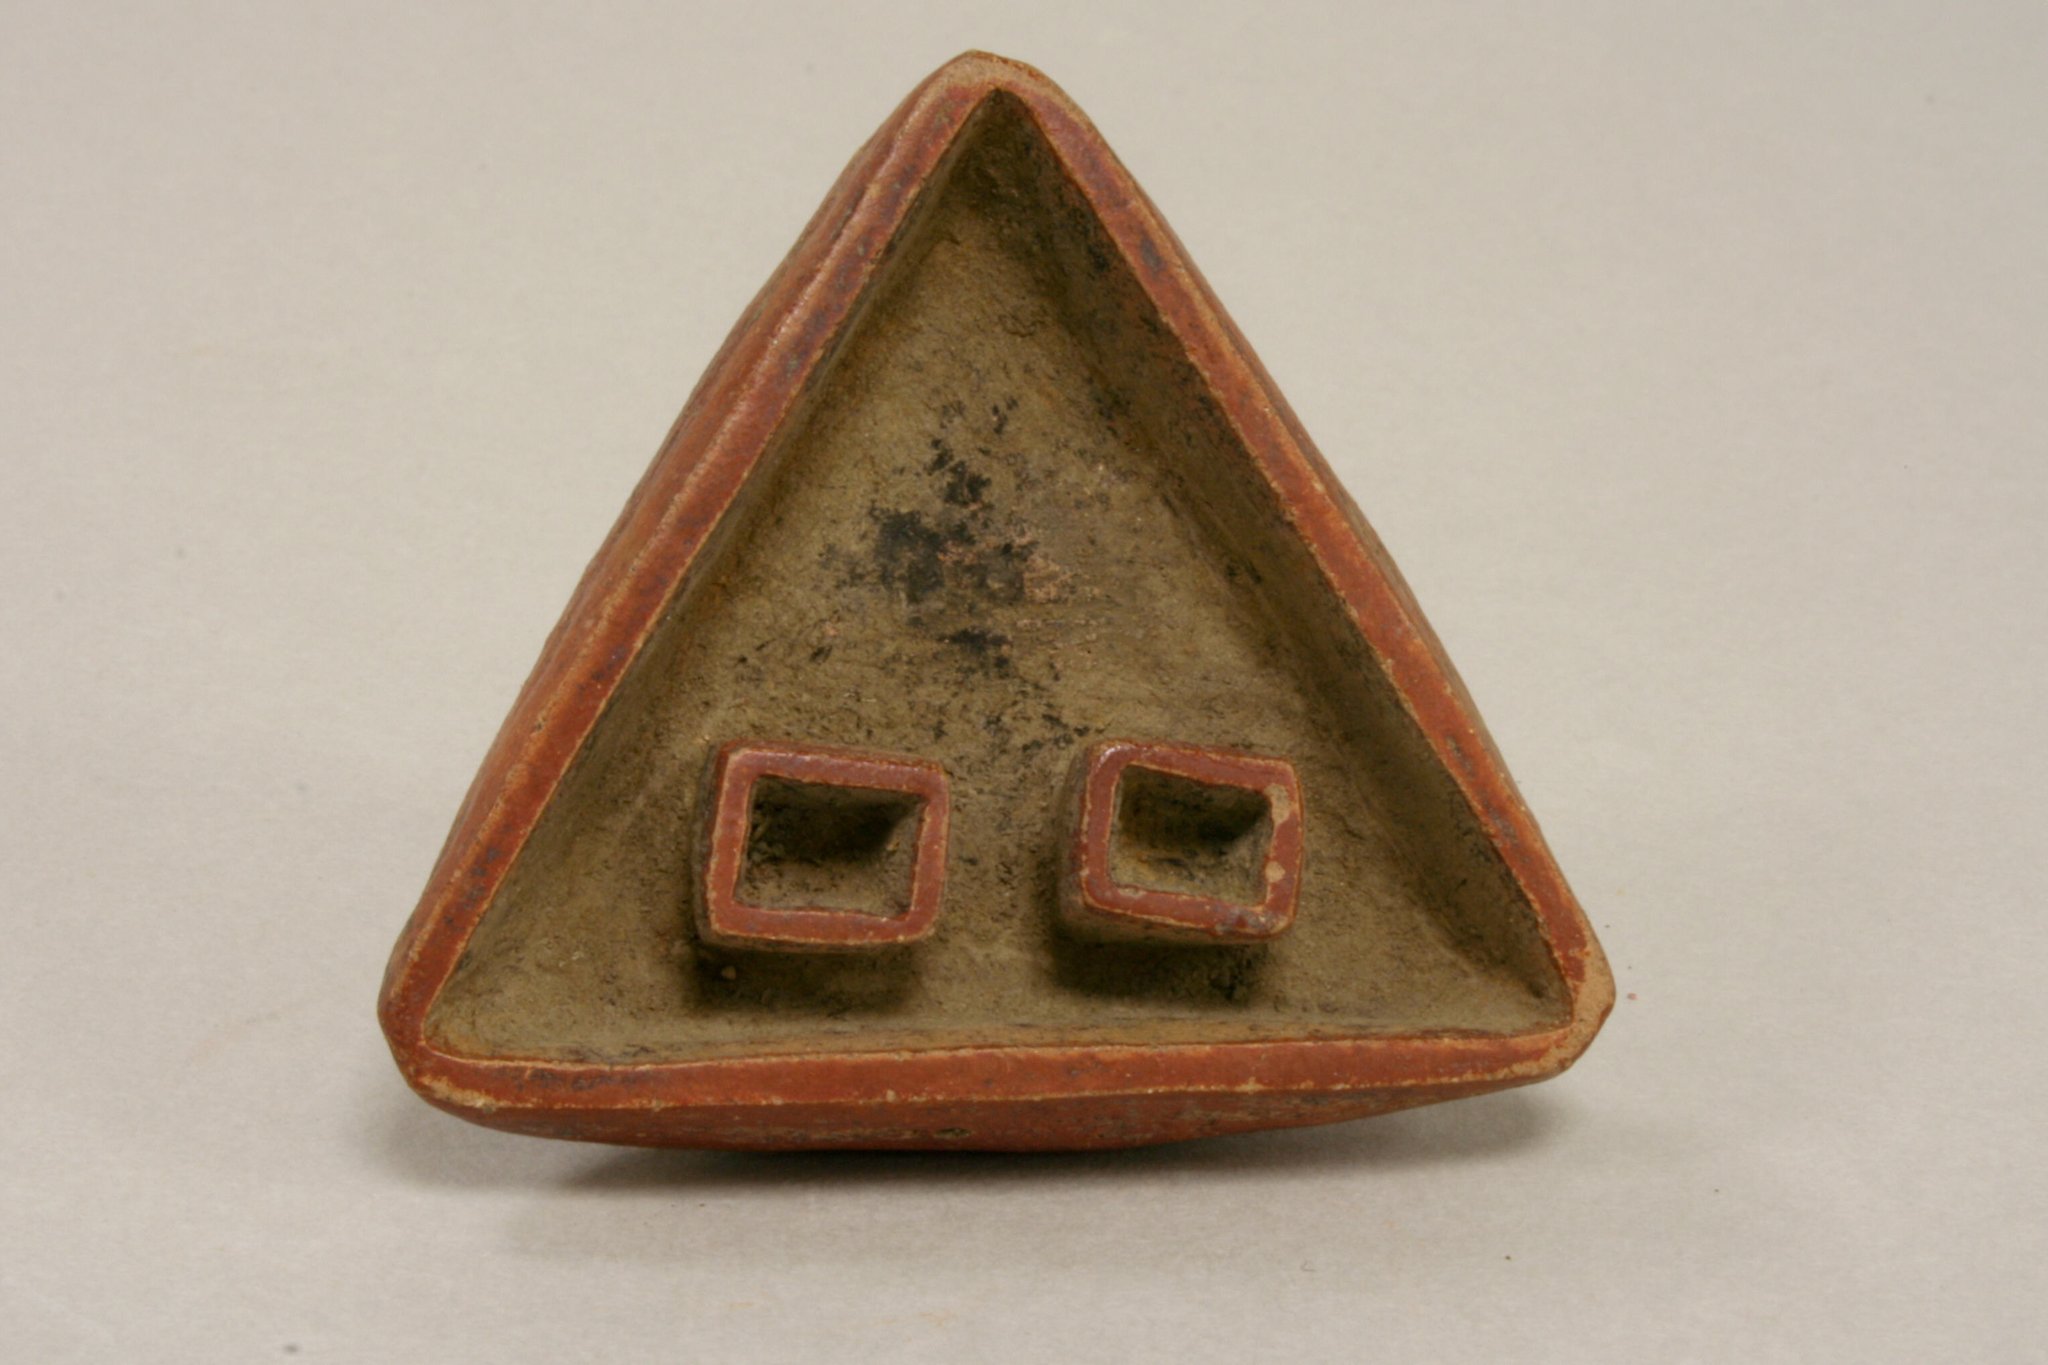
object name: stamp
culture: atlantic watershed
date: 401-600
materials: ceramic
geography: costa rica